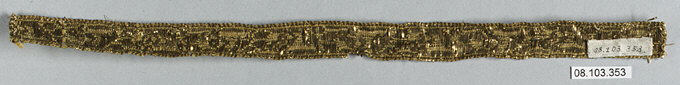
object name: galloon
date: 1601-1800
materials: metal thread